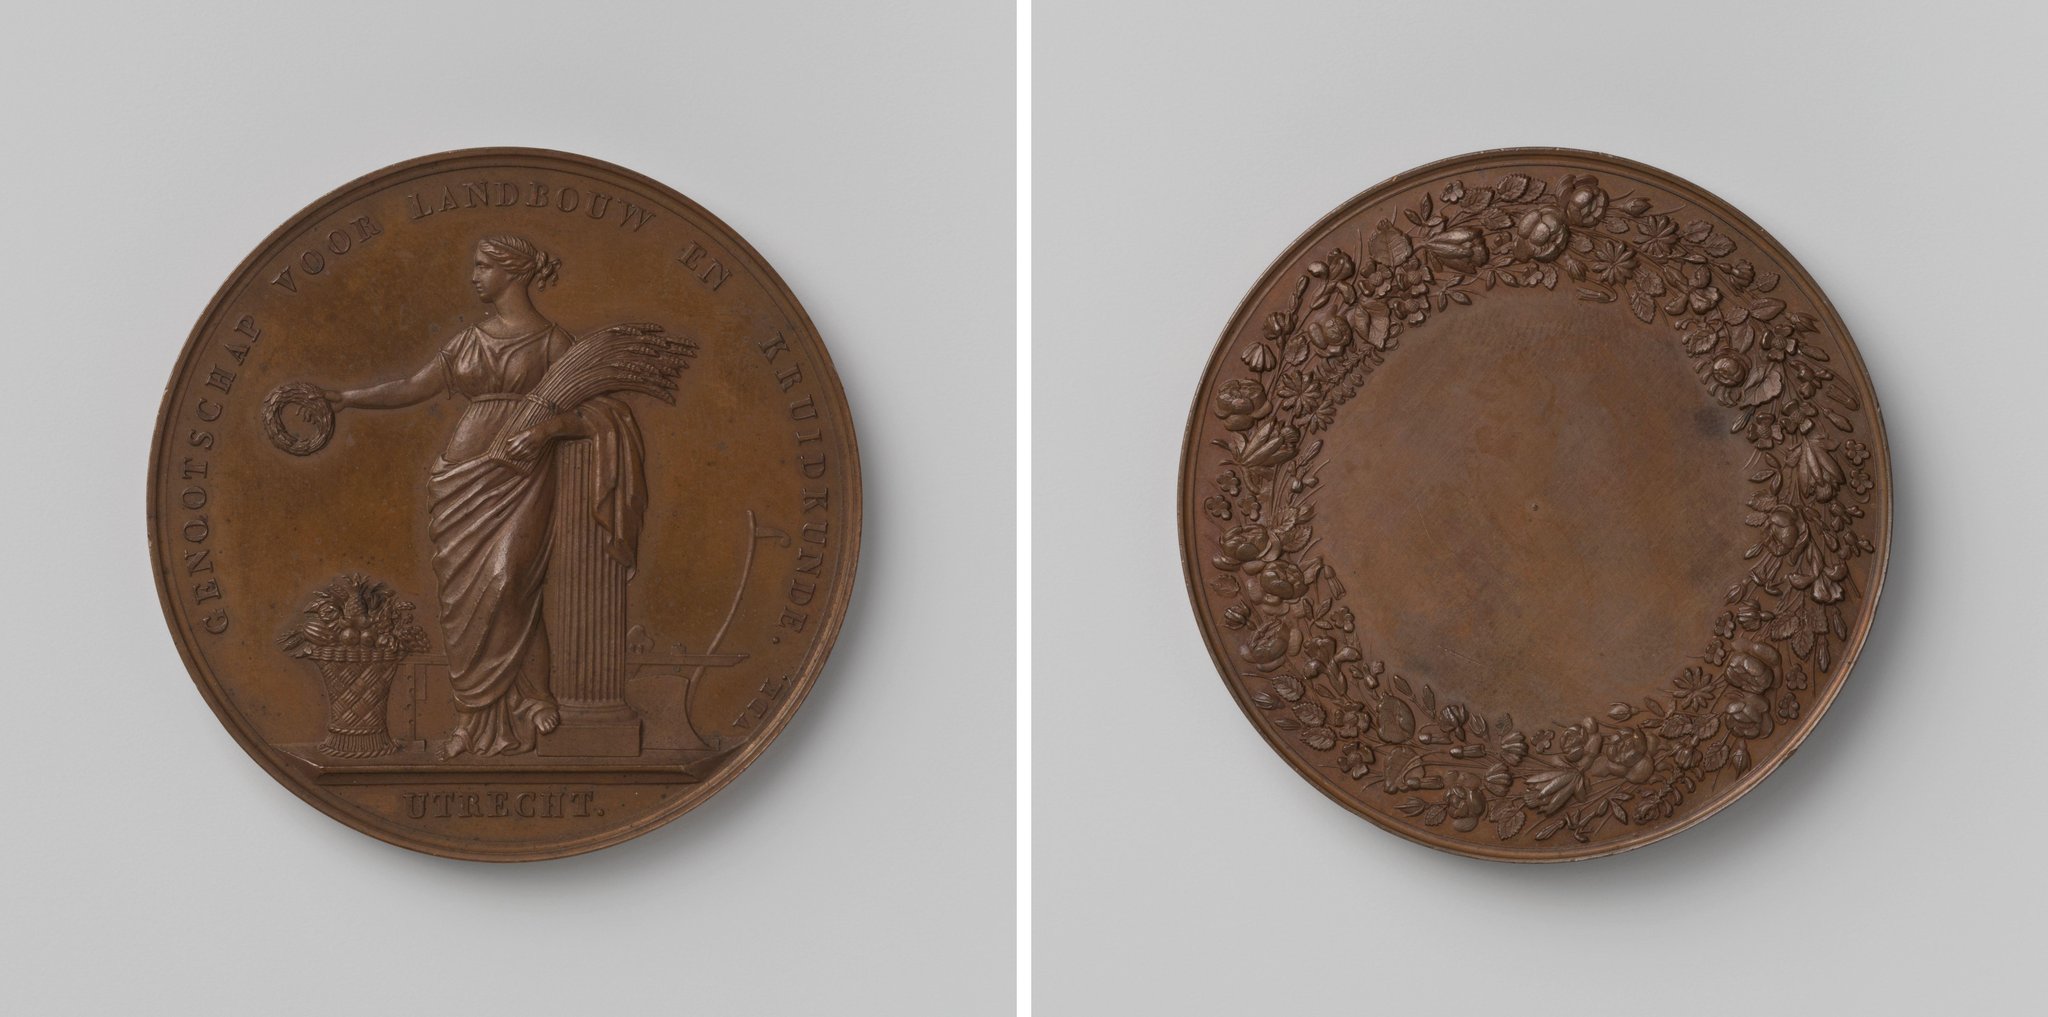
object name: medal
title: Genootschap voor landbouw en kruidkunde te Utrecht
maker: david van der kellen (1804-1879)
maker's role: die cutter, draughtsman, print maker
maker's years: 1804-1879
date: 1843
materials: bronze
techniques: striking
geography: utrecht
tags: utrecht